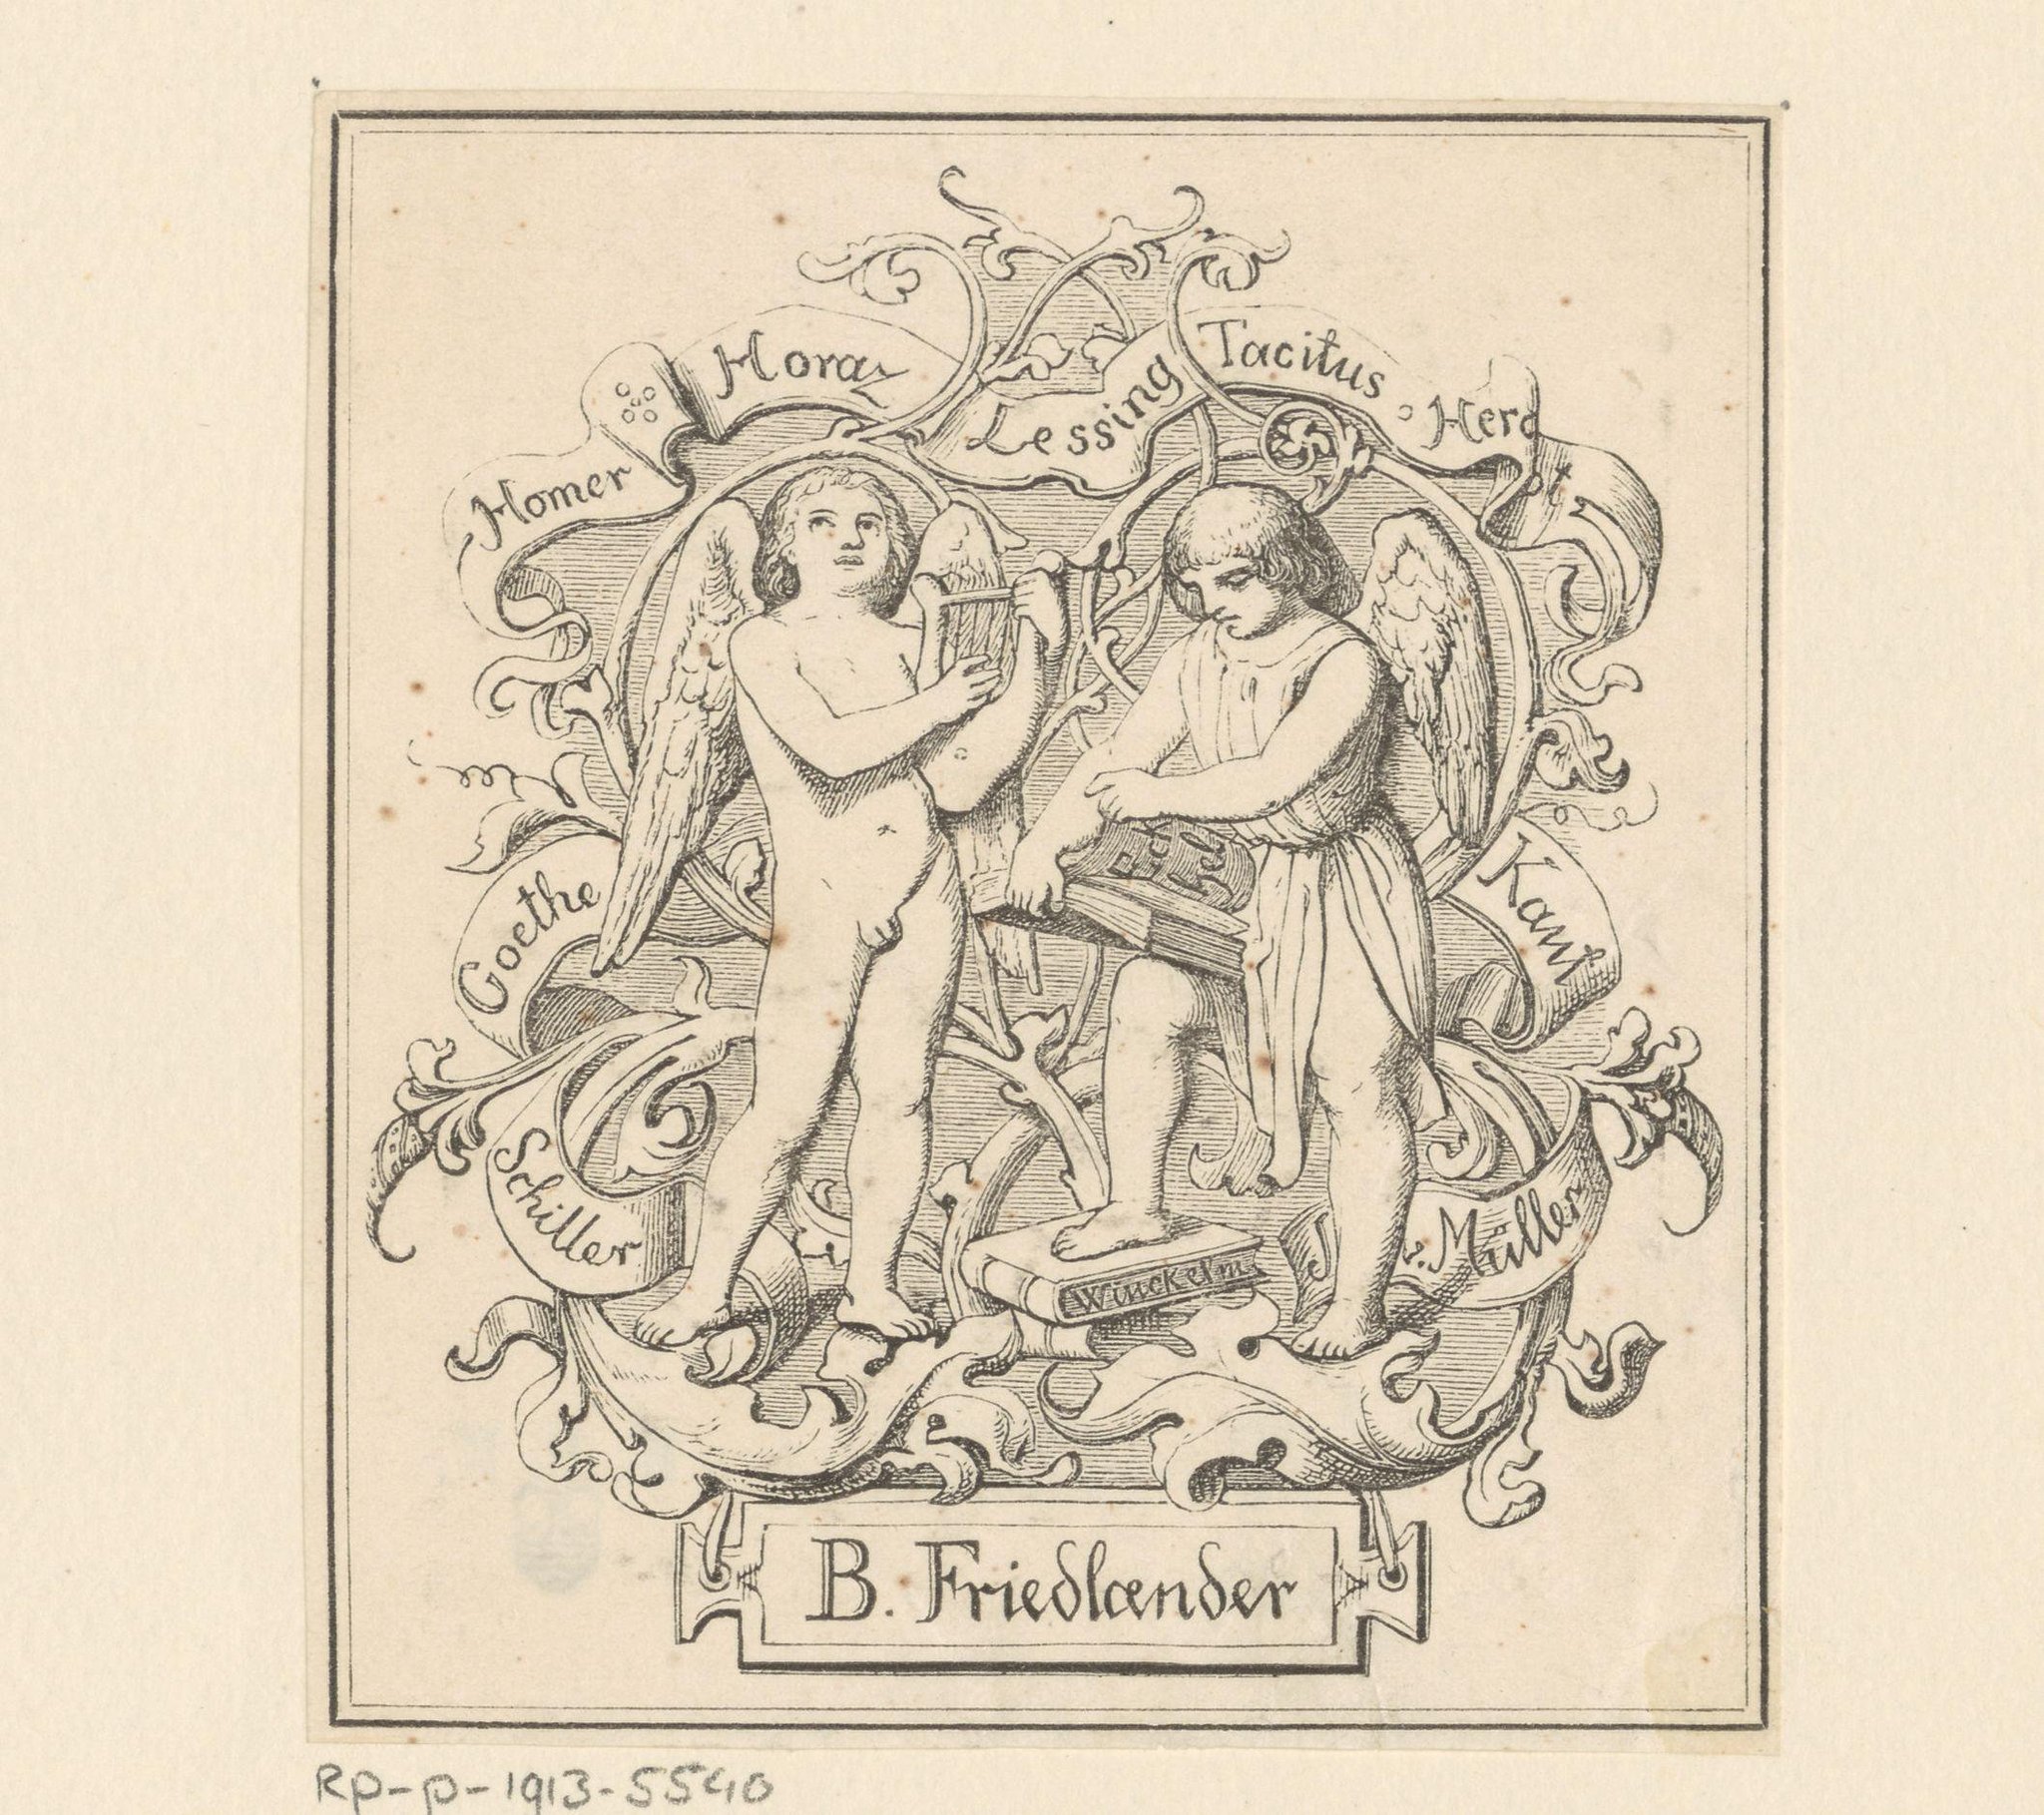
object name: bookplate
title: Schiller / Goethe / Homer / Horaz / Lessing / Tacitus / Hero[...]t / Kaut / Müller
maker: Anonymous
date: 1850-1899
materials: paper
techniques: printing block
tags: history of art, angels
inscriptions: collector's mark: Lugt 2760, collector's mark: Lugt 2233